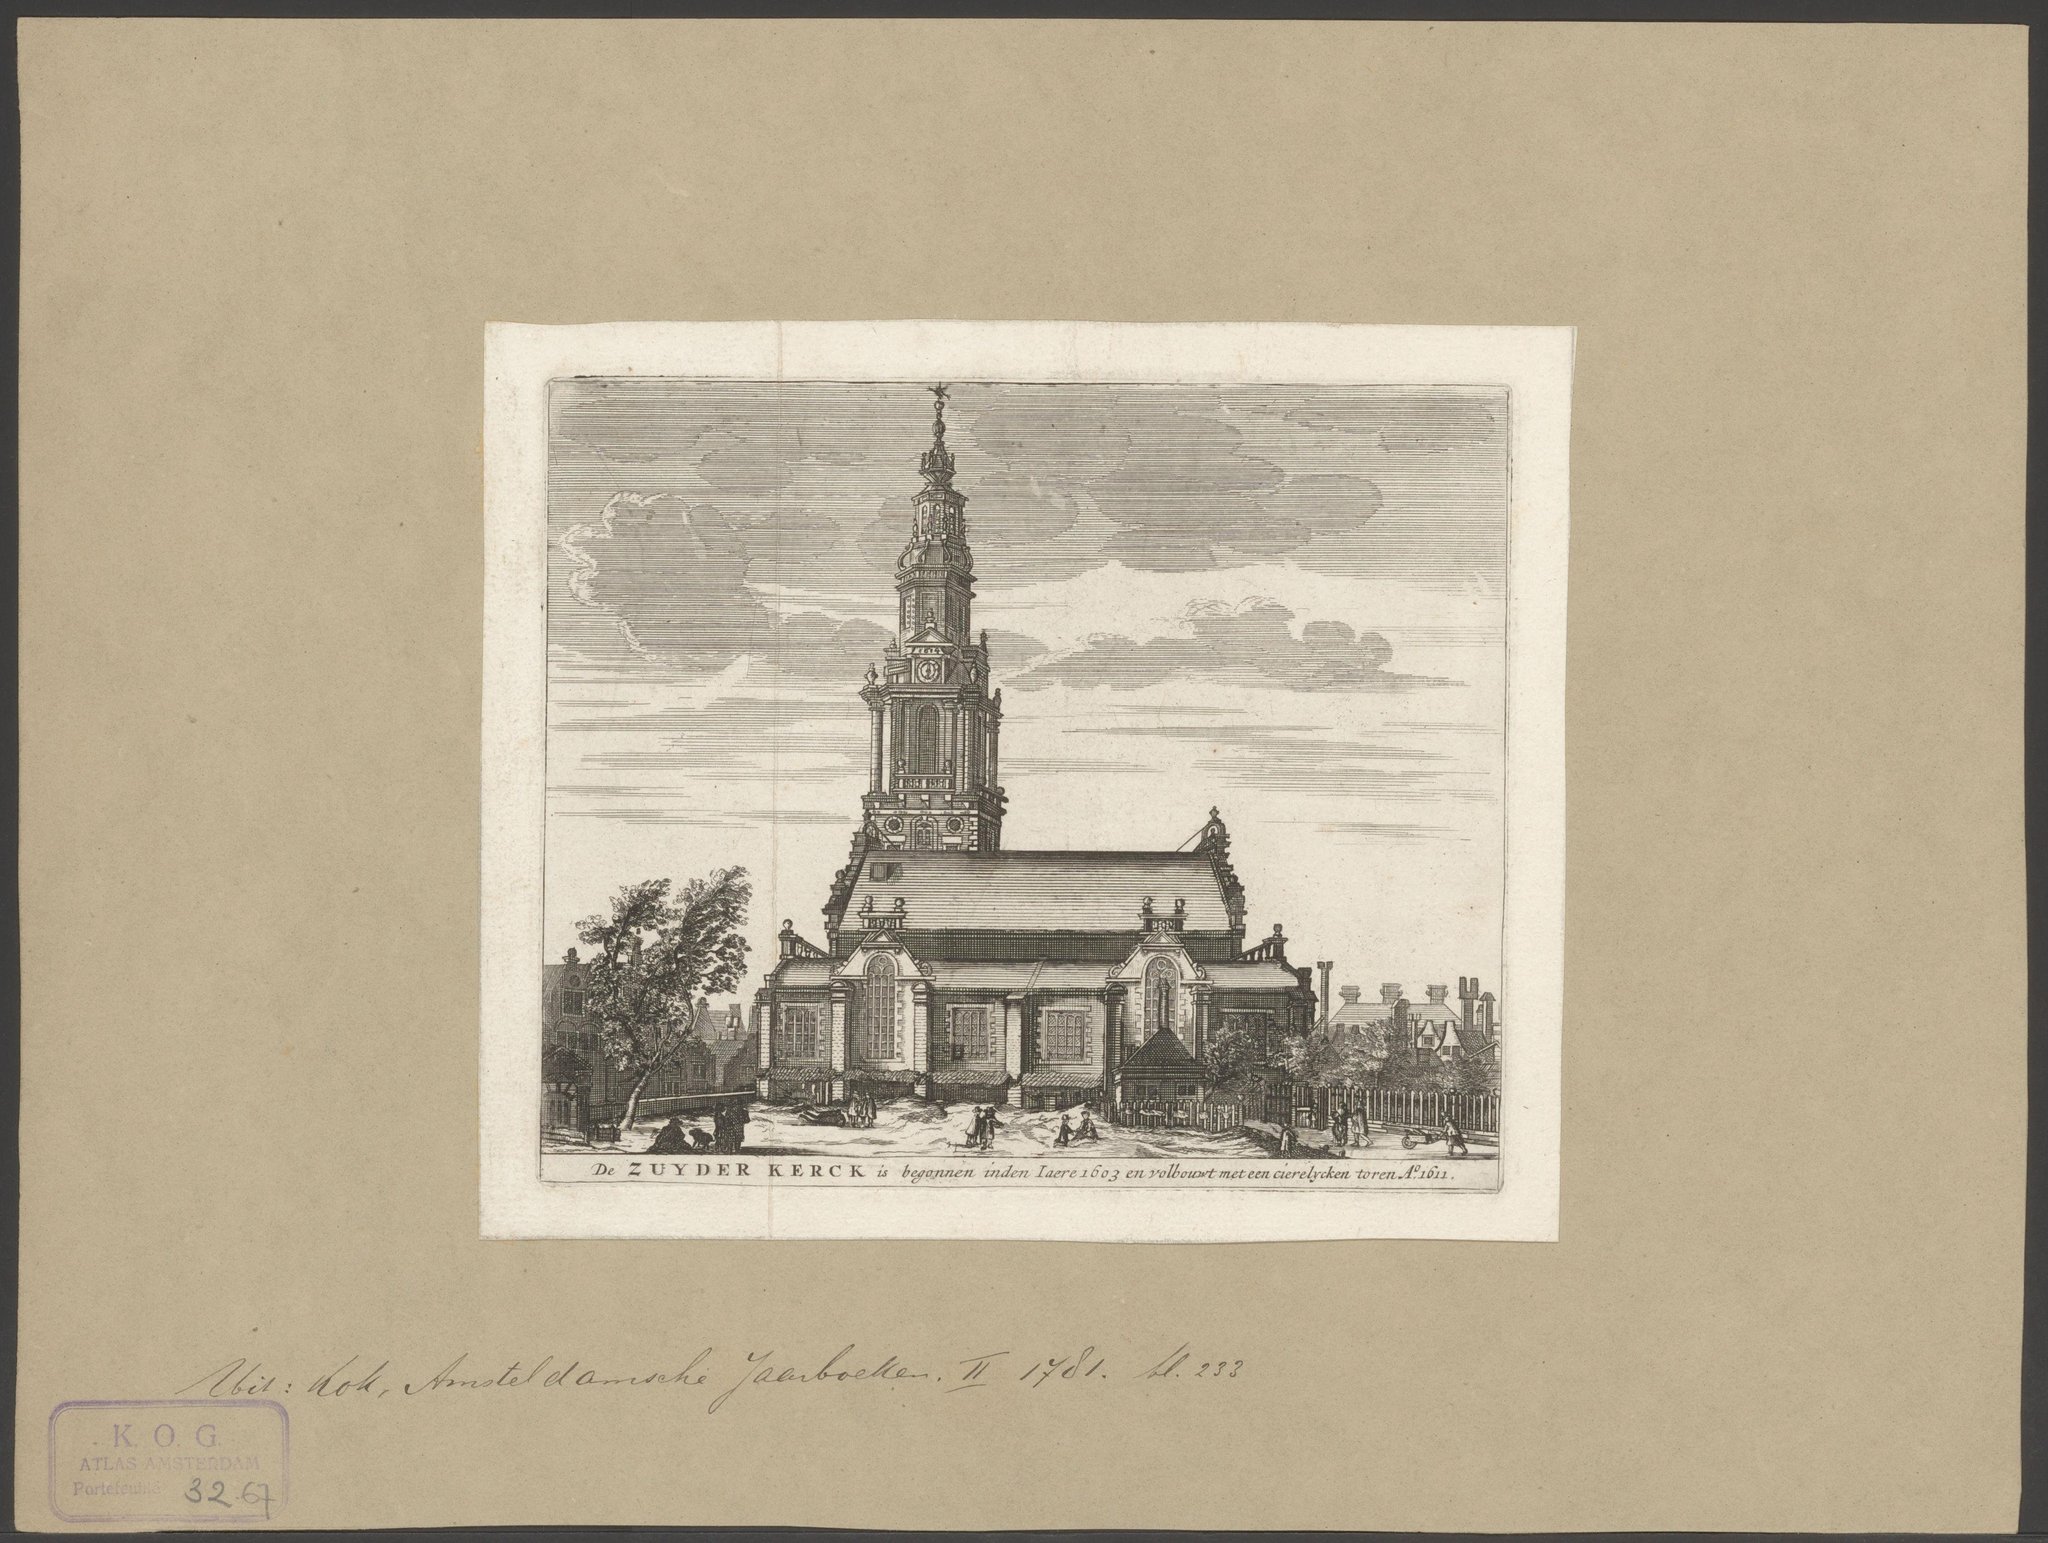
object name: print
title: De Zuyder Kerck is begonnen inden Iaere 1603 en volbouwt met een cierelycken toren Ao. 1611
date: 1781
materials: paper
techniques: engraving, etching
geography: northern netherlands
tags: church (exterior), churchyard, cemetery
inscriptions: collector's mark: Lugt 1641b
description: Prent mogelijk uit: Kok, Jacobus. Amsteldamsche jaarboeken, behelzende de merkwaardigste geschiedenissen (...). Amsterdam: Jan Barend Elwe, 1781, dl. 2.